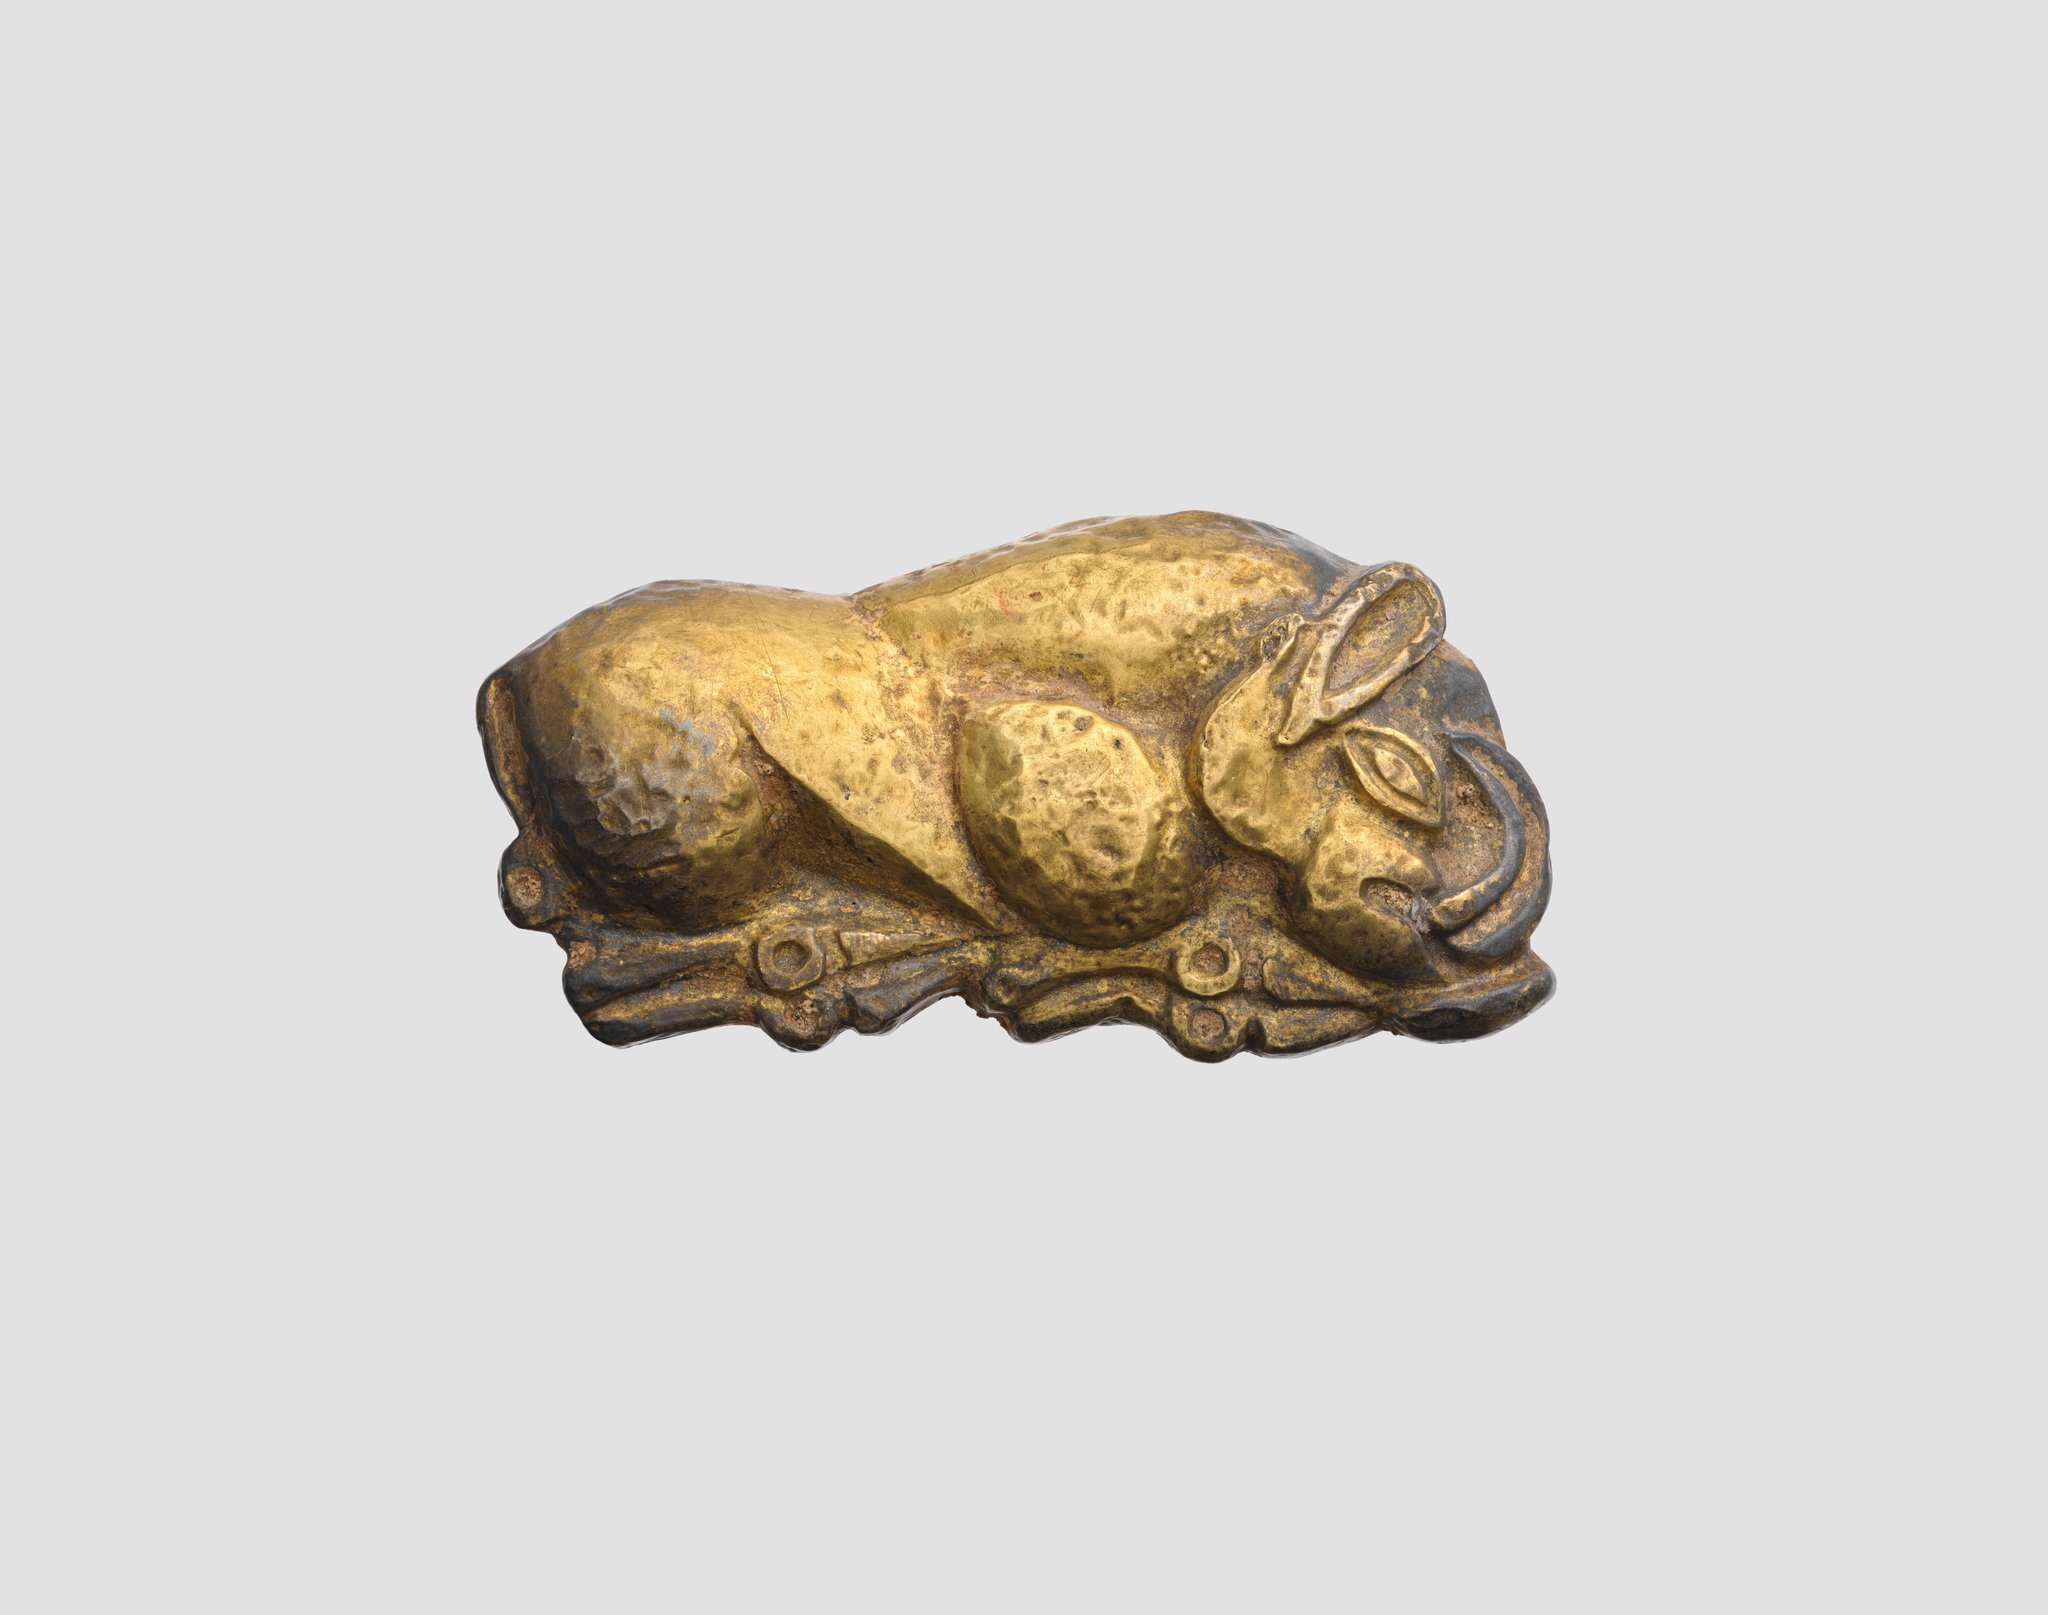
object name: harness or bridle ornament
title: Harness or bridle ornament in the form of a boar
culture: scythian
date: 500-401 BCE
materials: bone, gold, silver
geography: eurasian steppes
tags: boars